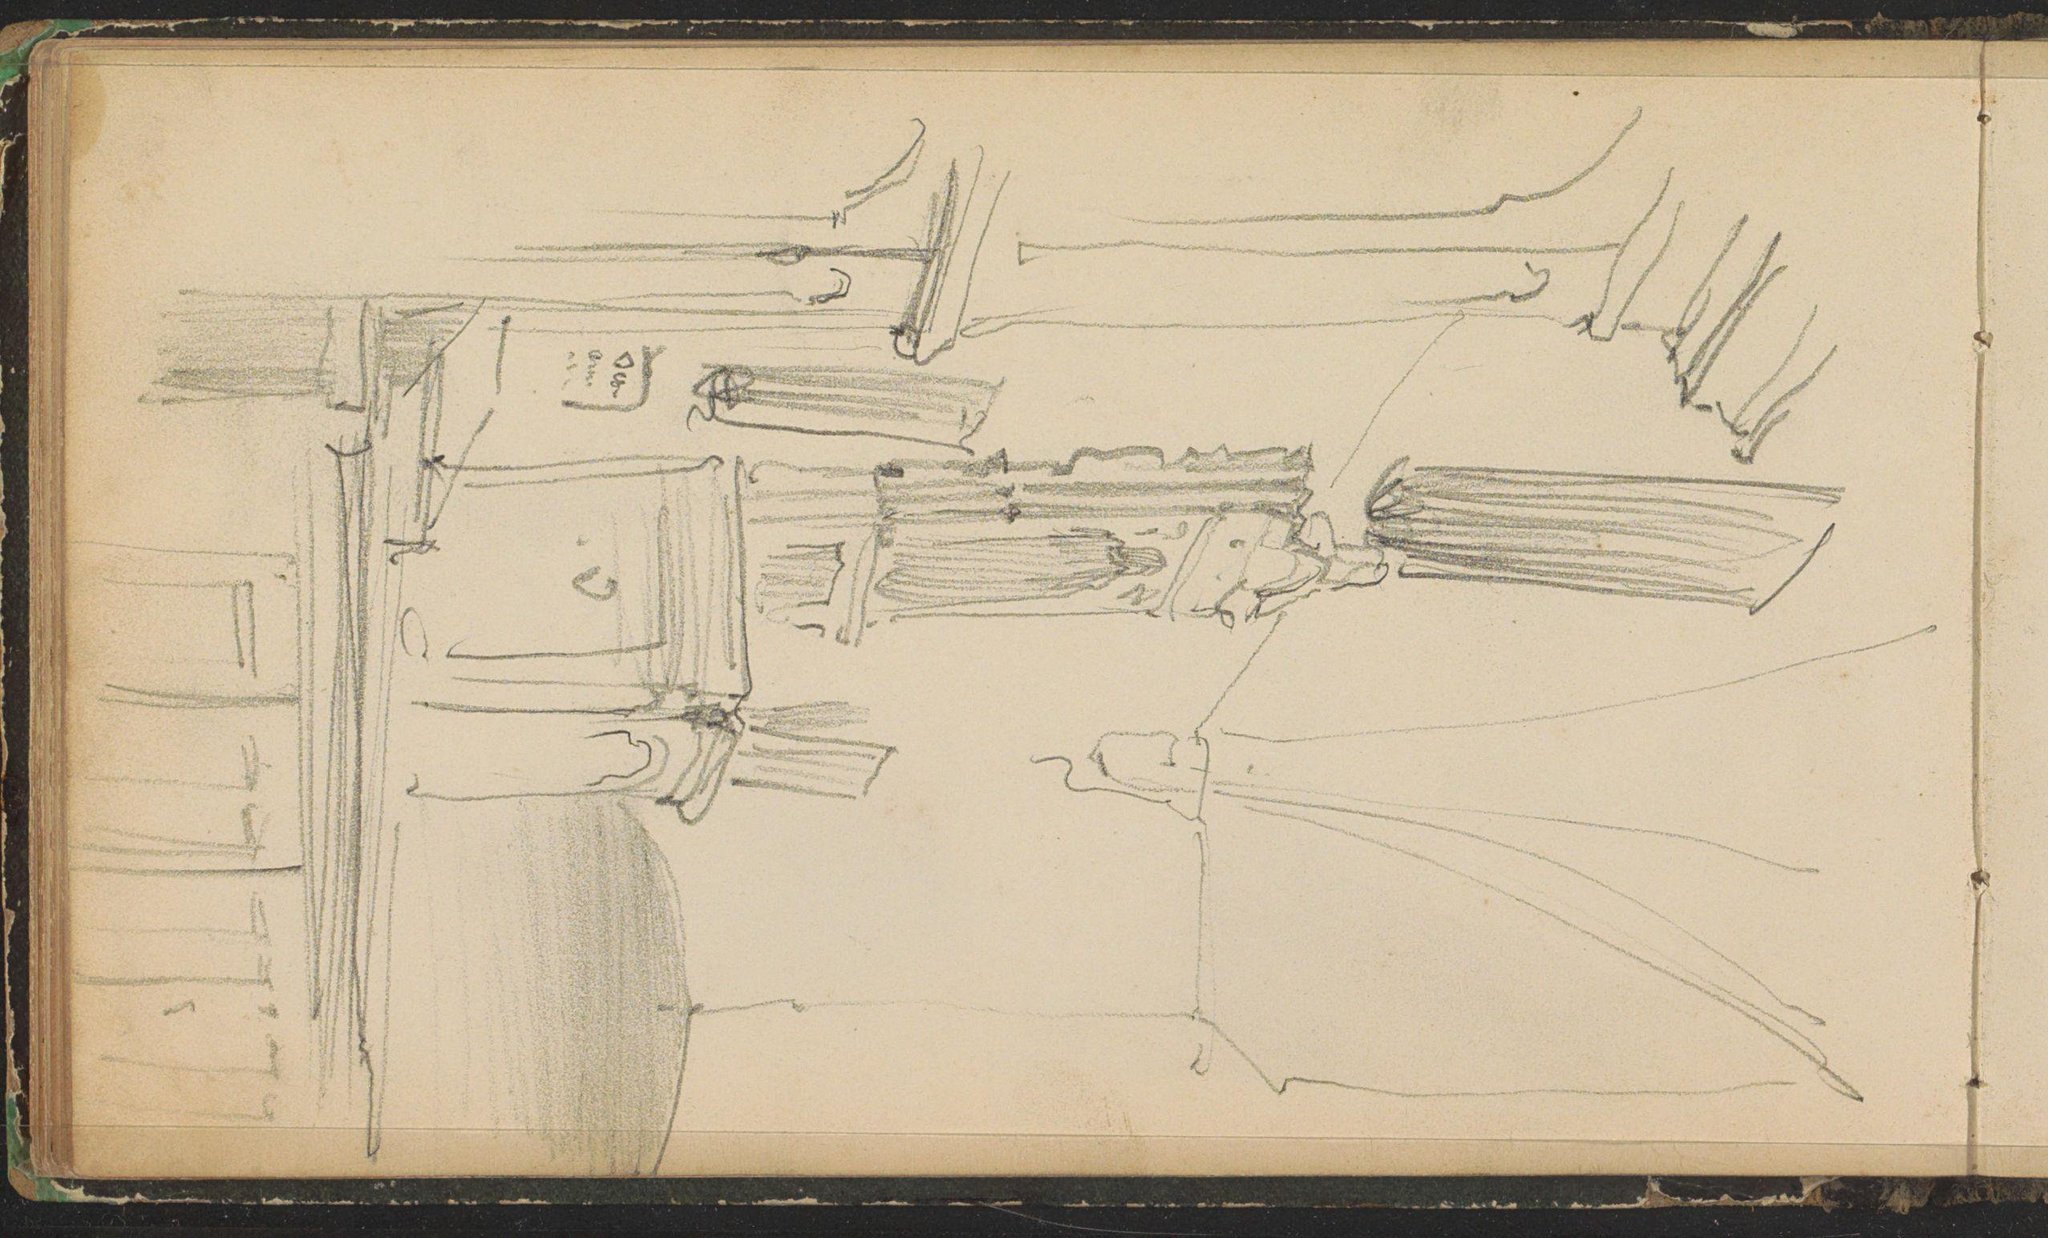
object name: sketchbook leaf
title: Spreekgestoelte in een kerk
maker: johannes bosboom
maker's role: draughtsman, painter, print maker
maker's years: 1817-1891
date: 1845-1891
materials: paper, pencil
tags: parts of church interior, pulpit, ambo, chancel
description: Blad 34 verso uit een schetsboek met 46 bladen.